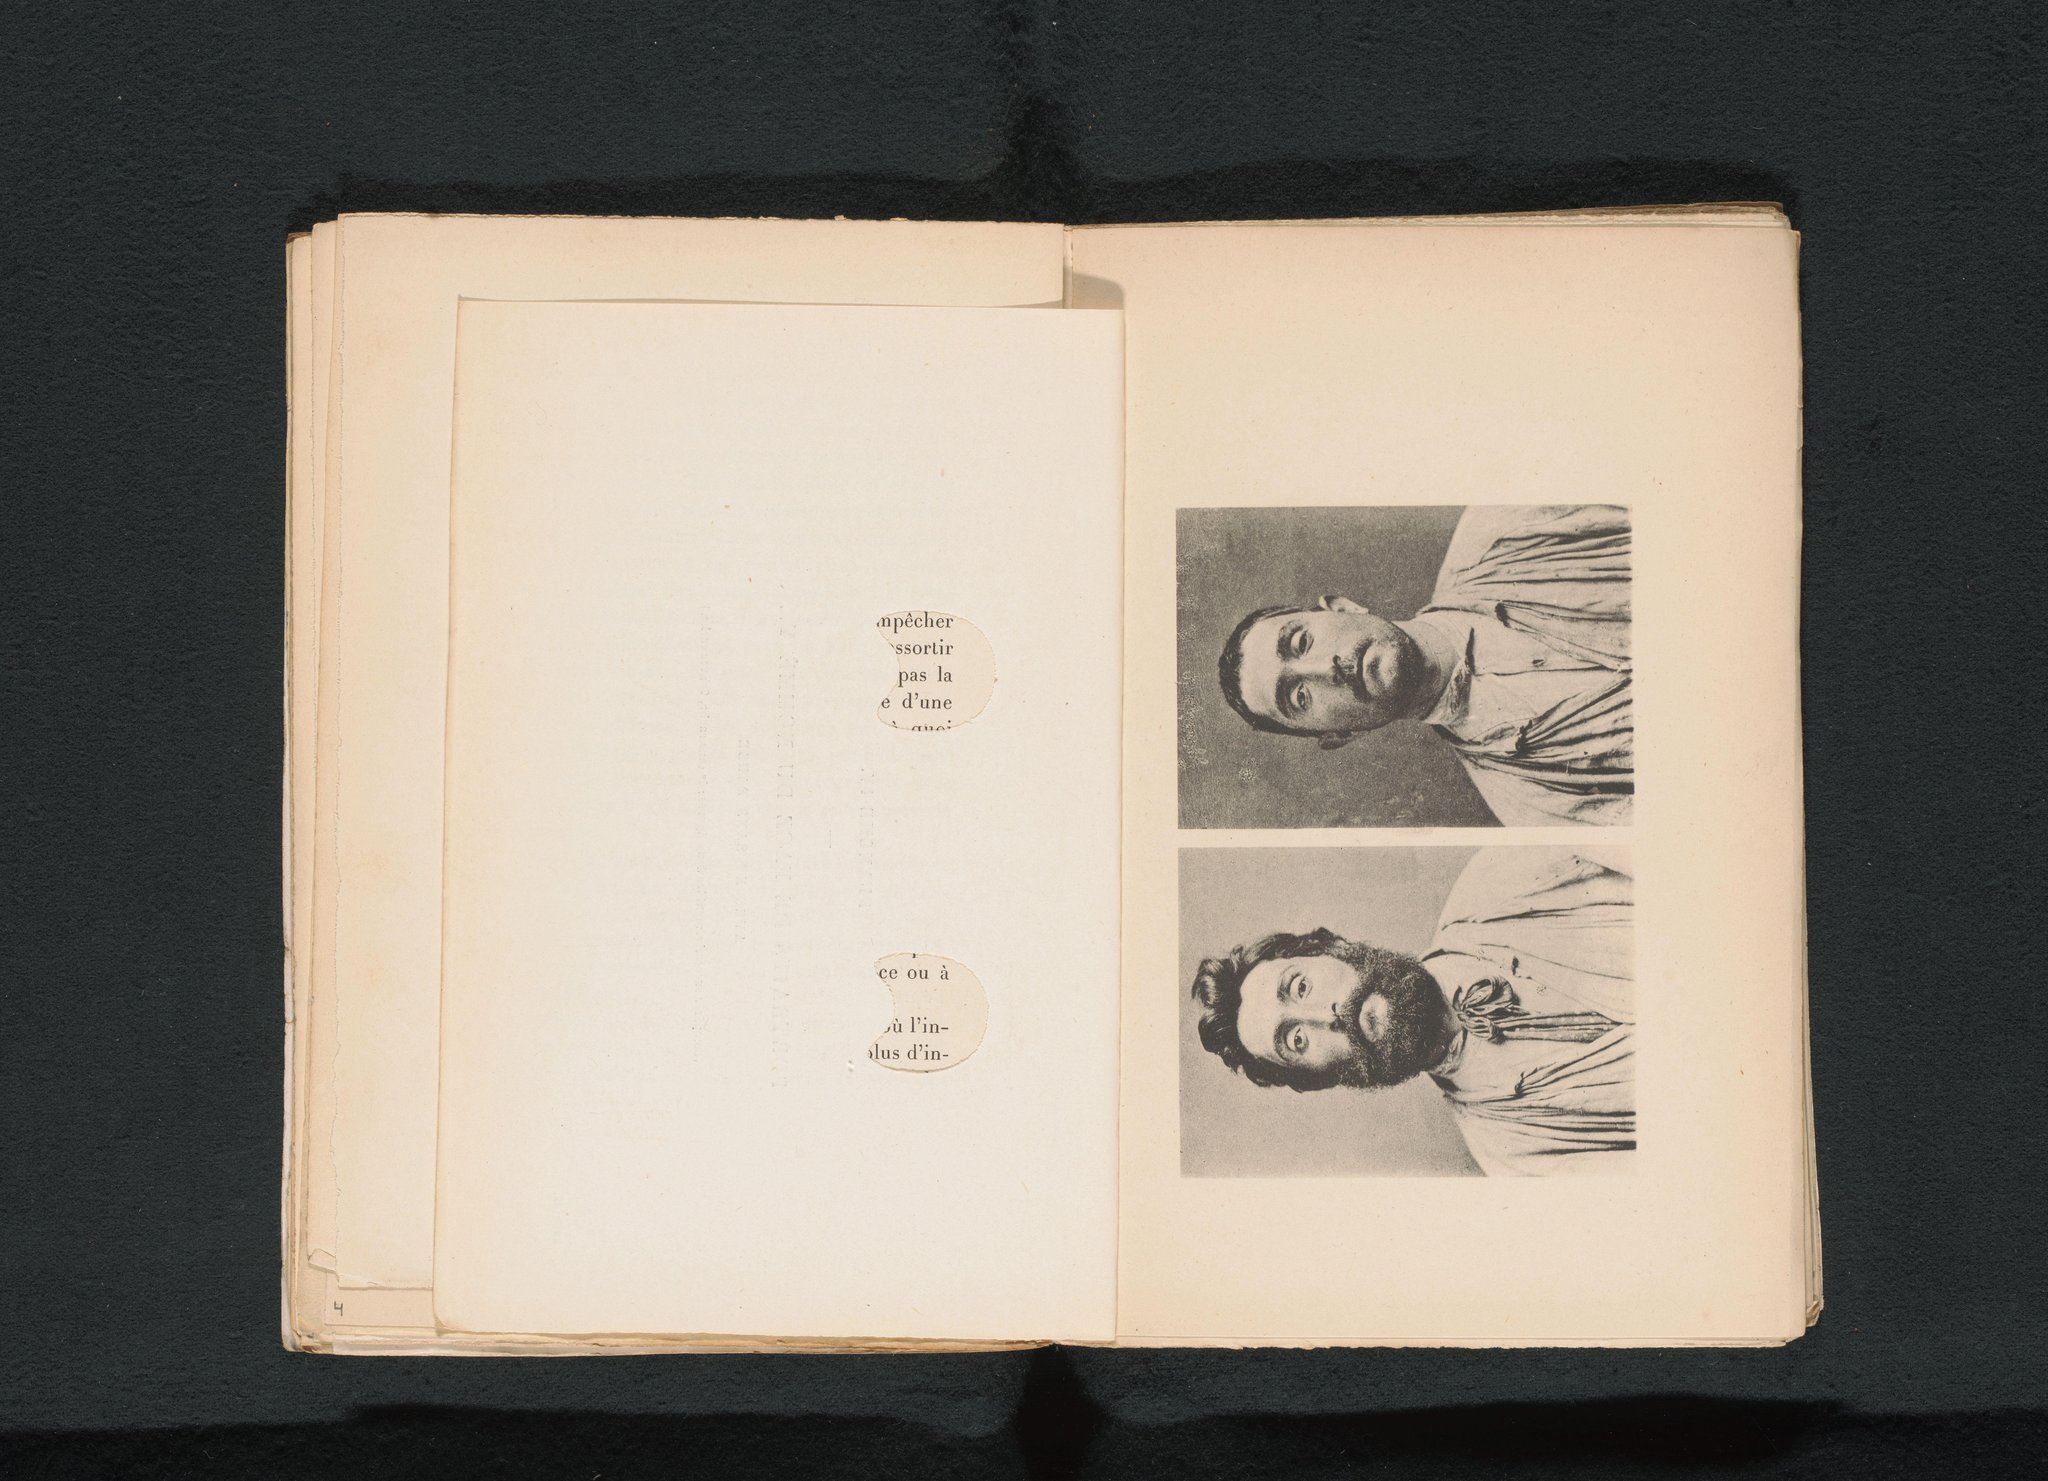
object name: photomechanical print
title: Twee gerechtelijke portretten van een onbekende man, met baard en zonder baard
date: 1885-1890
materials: paper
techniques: photograph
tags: historical persons, law and jurisprudence, beard